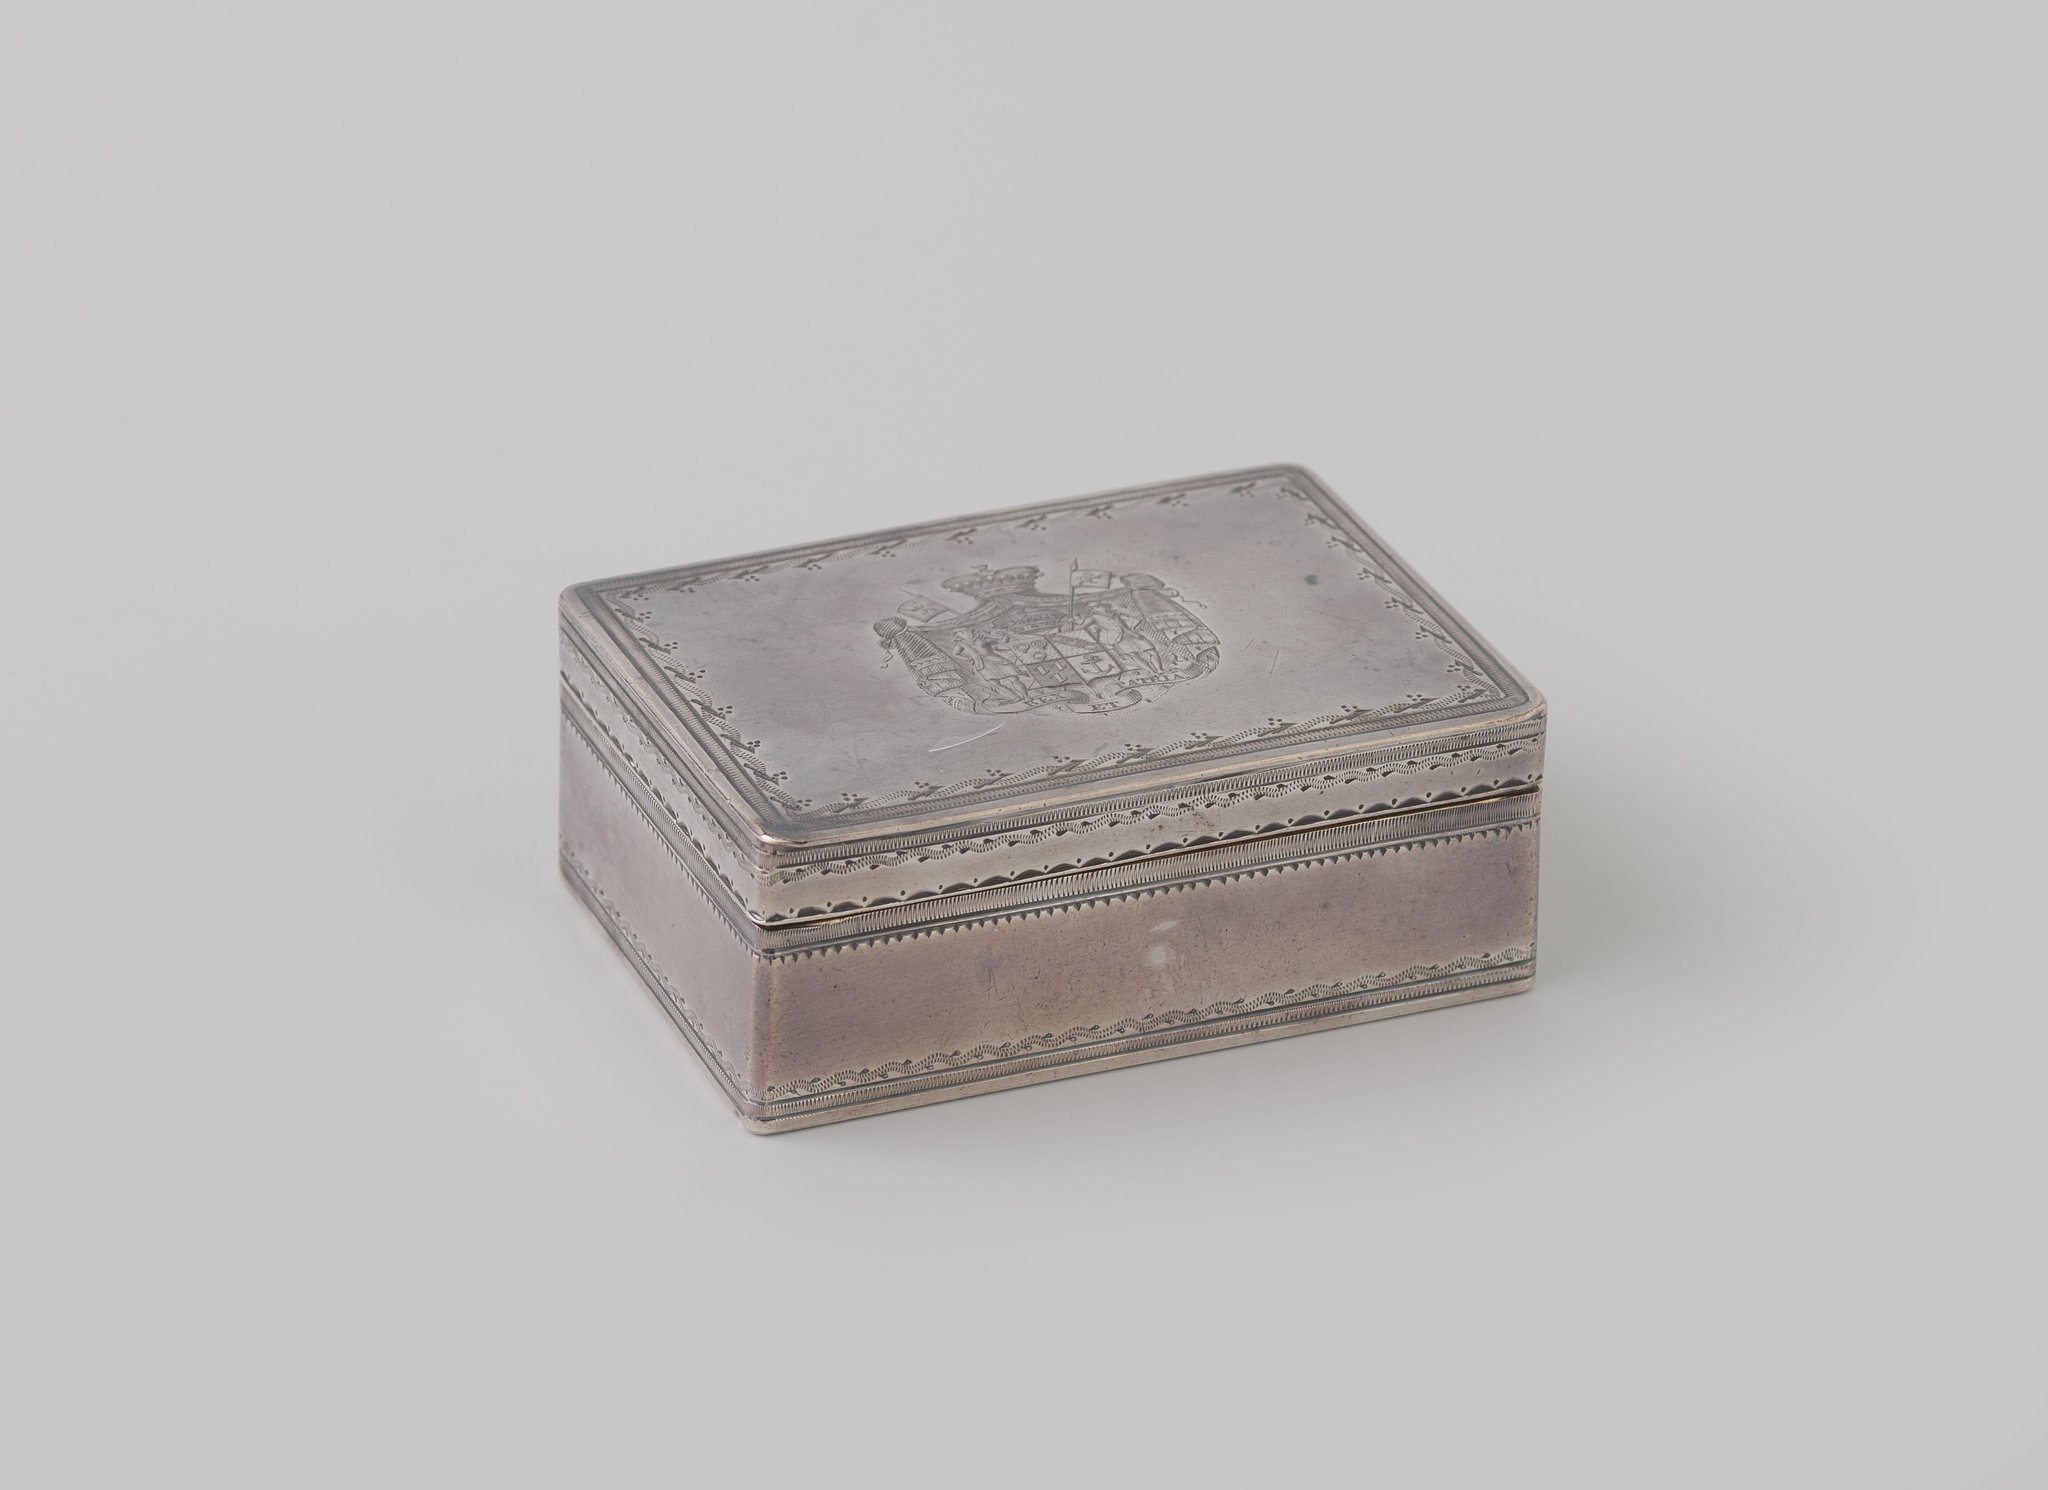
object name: snuffbox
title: Snuifdoos van C.H. Ver Huell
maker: antoine moranges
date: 1794-1797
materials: silver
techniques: gilding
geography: paris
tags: paris, armorial bearing, heraldry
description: Vierkante snuifdoos van zilver van binnen verguld. Op het deksel is het gekroonde wapen met mantel van admiraal C.H. Ver Huell gegraveerd.